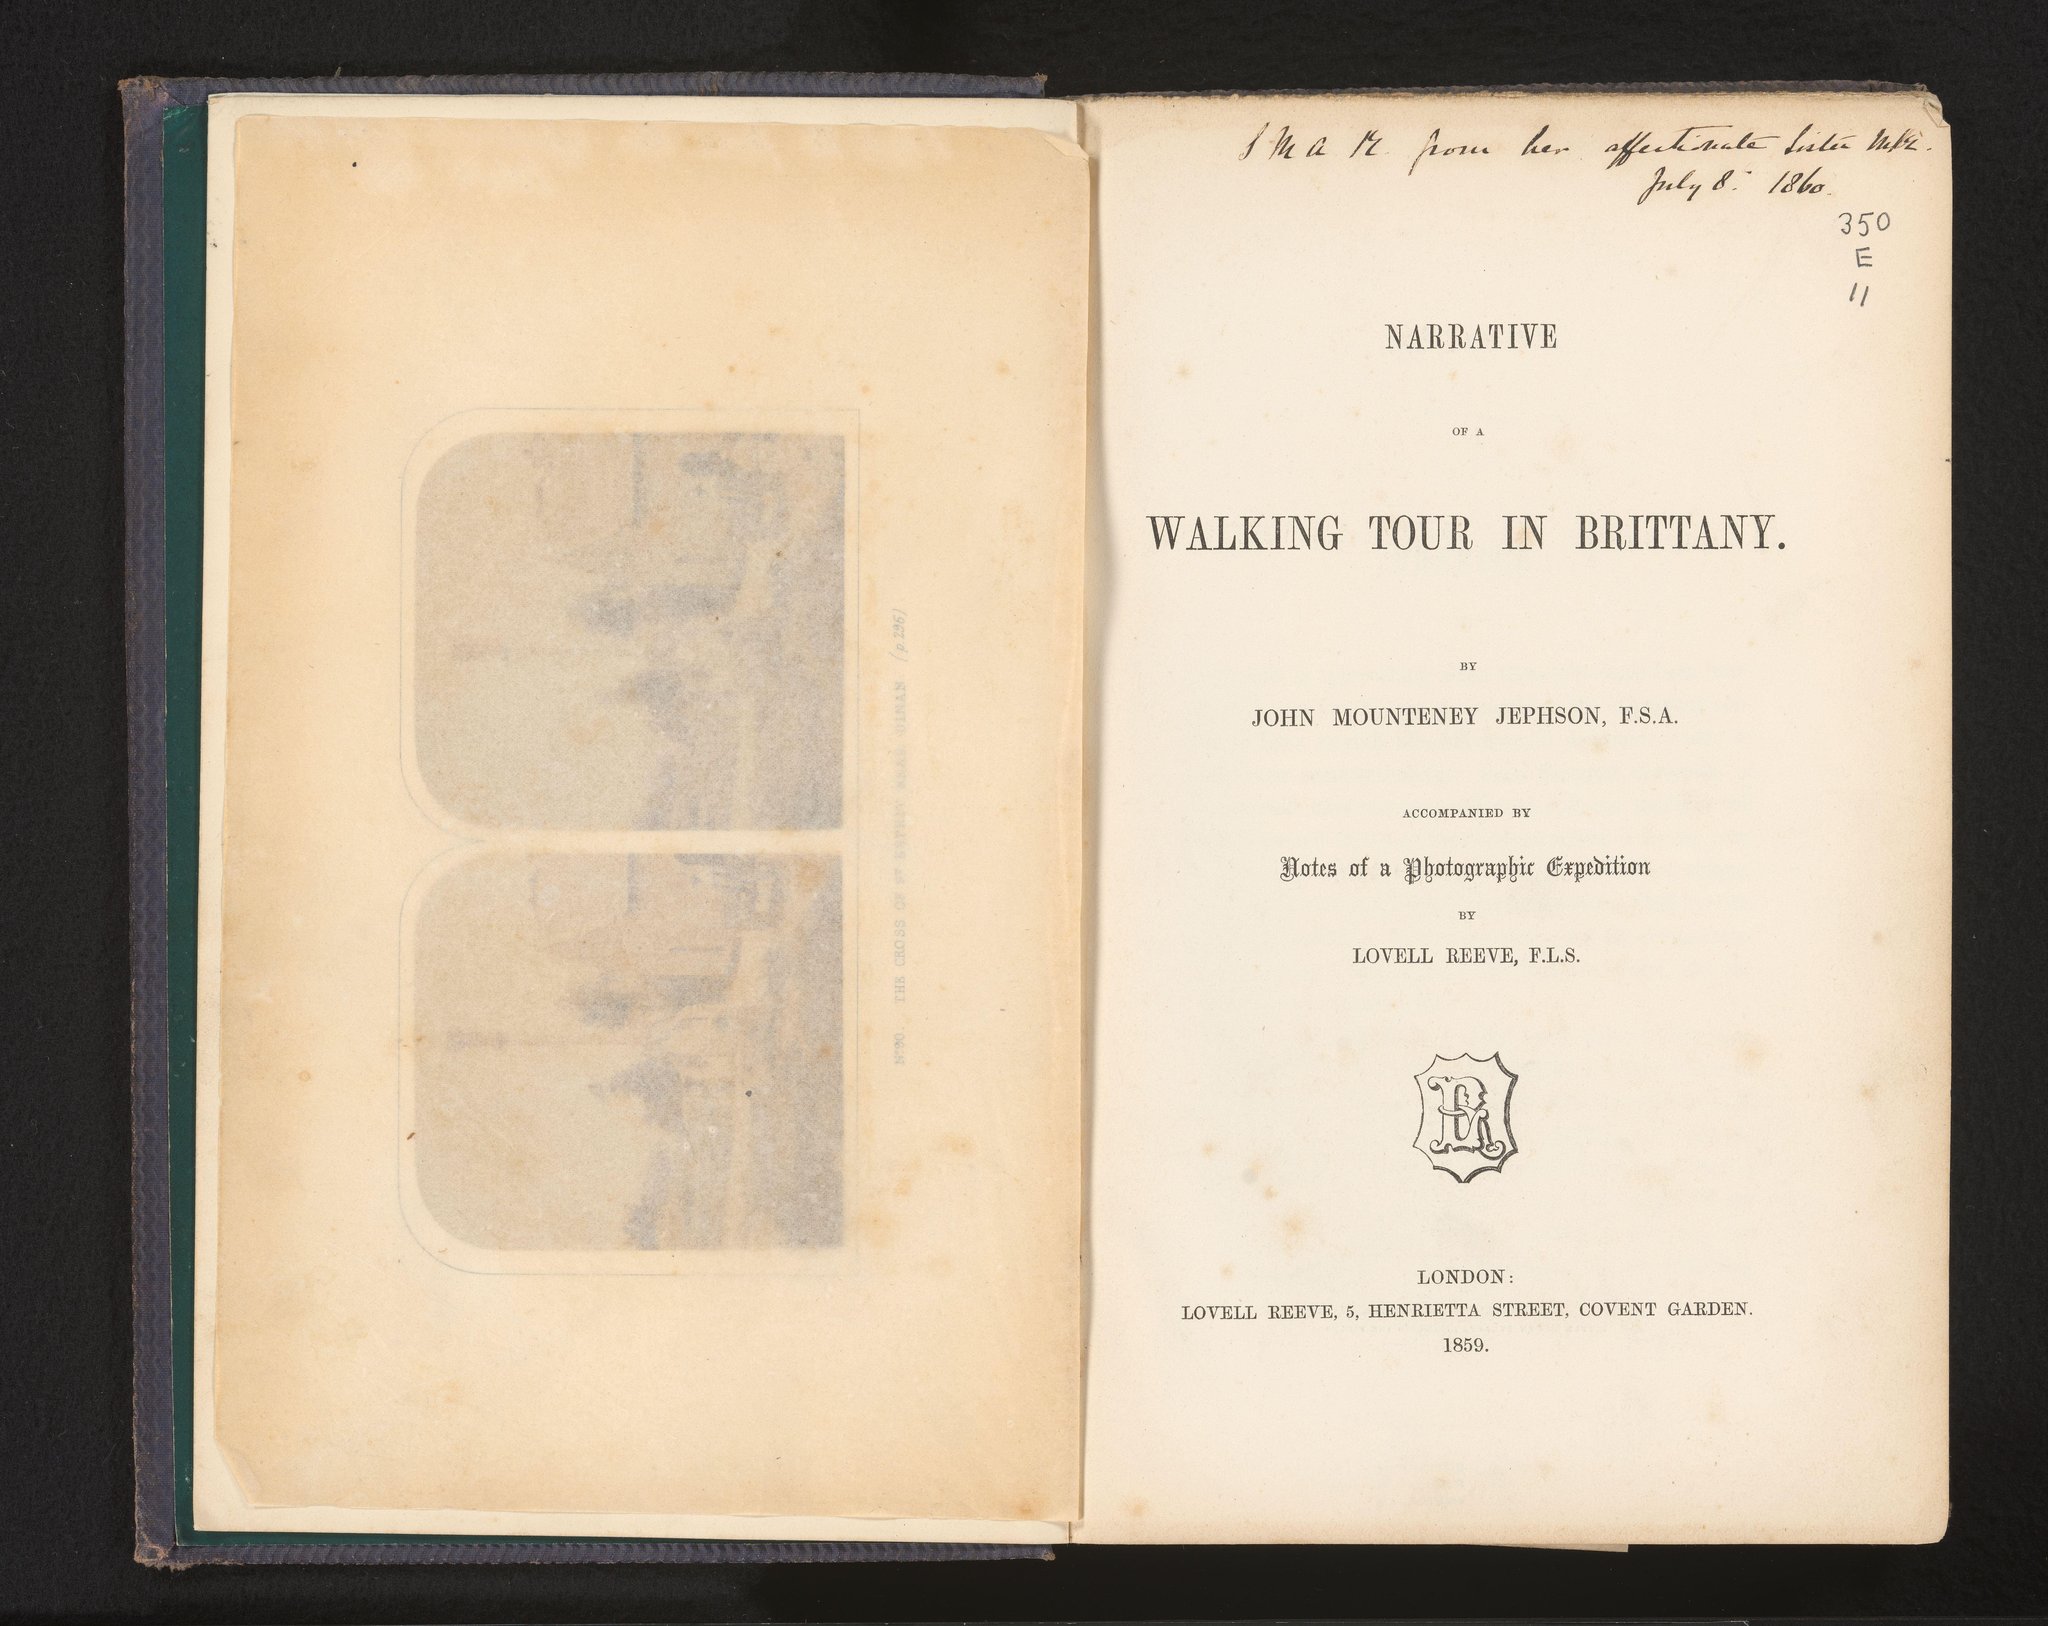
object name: book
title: Narrative of a walking tour in Brittany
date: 1859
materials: cardboard, paper, linen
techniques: albumen print, letterpress printing, lithograph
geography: london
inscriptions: inscription: ‘BOUND BY/ WESTLEYS/ & Co./ LONDON.’, inscription: ‘Rijksdienst Beeldende/ Kunst’, inscription: ‘[...] from her affectionate sister [...]// July 8 1860’, inscription: ‘1859/ CONTAINS FRONTIS./ OF TWO EARLY PHOTOS.’